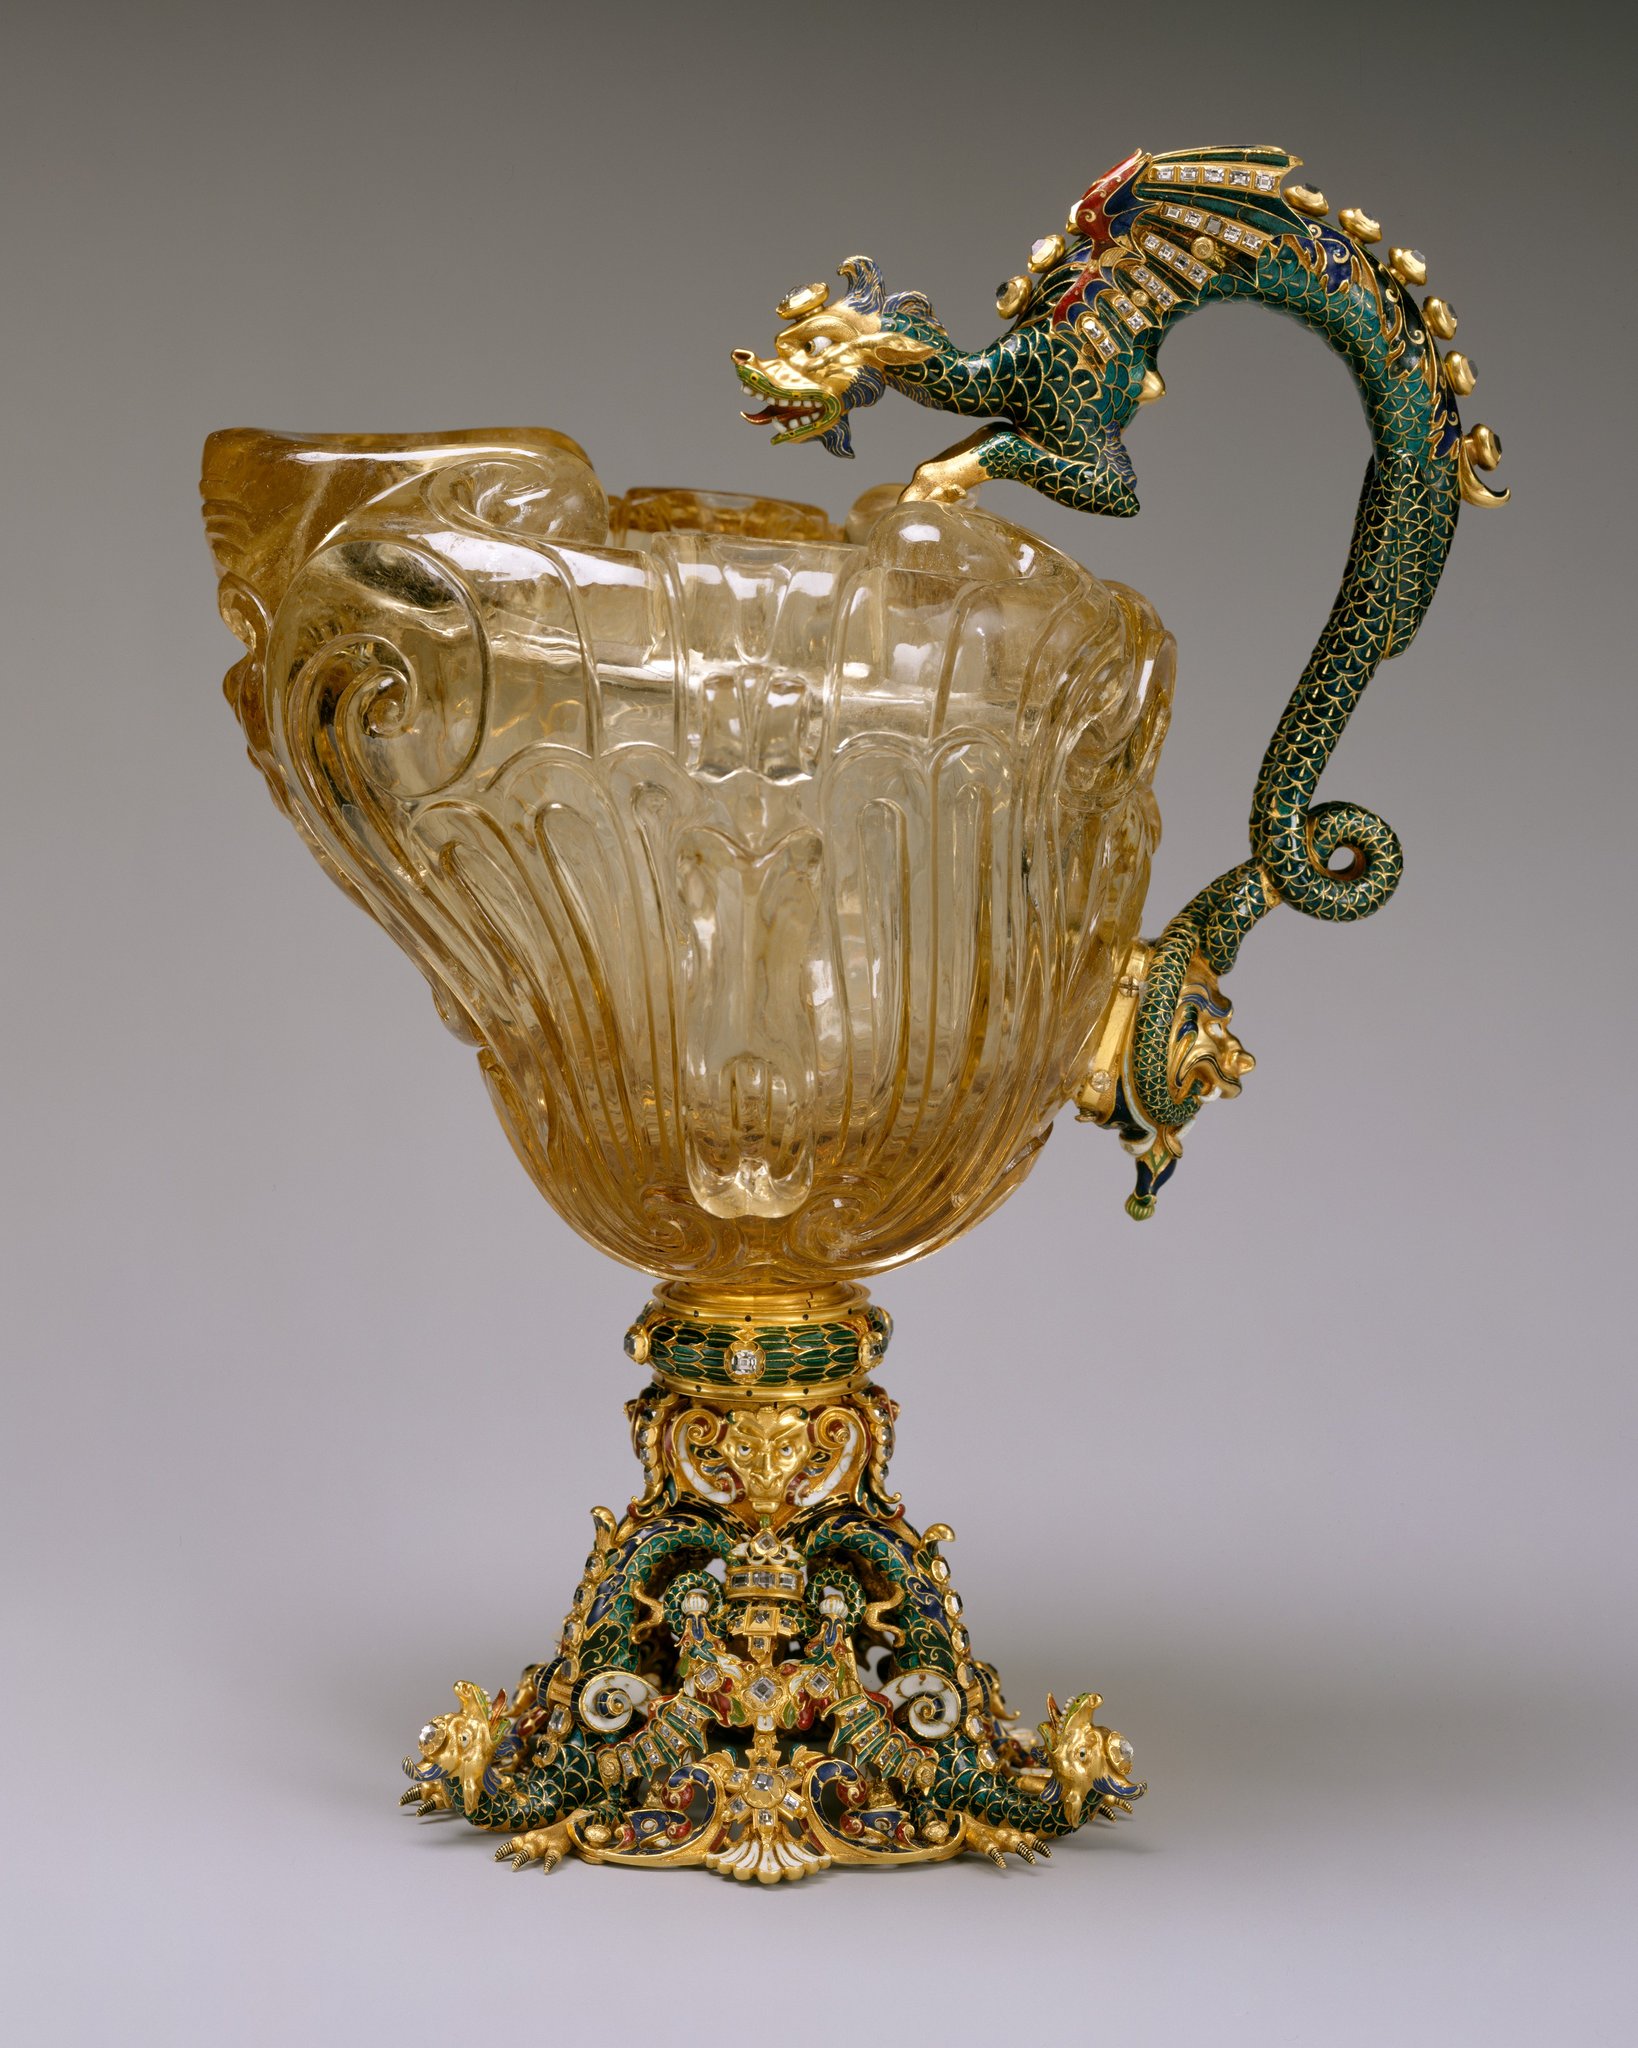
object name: ewer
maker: ferdinand eusebio miseroni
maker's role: maker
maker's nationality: italian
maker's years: 1656-1684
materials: diamond, enamel, gold, quartz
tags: dragons